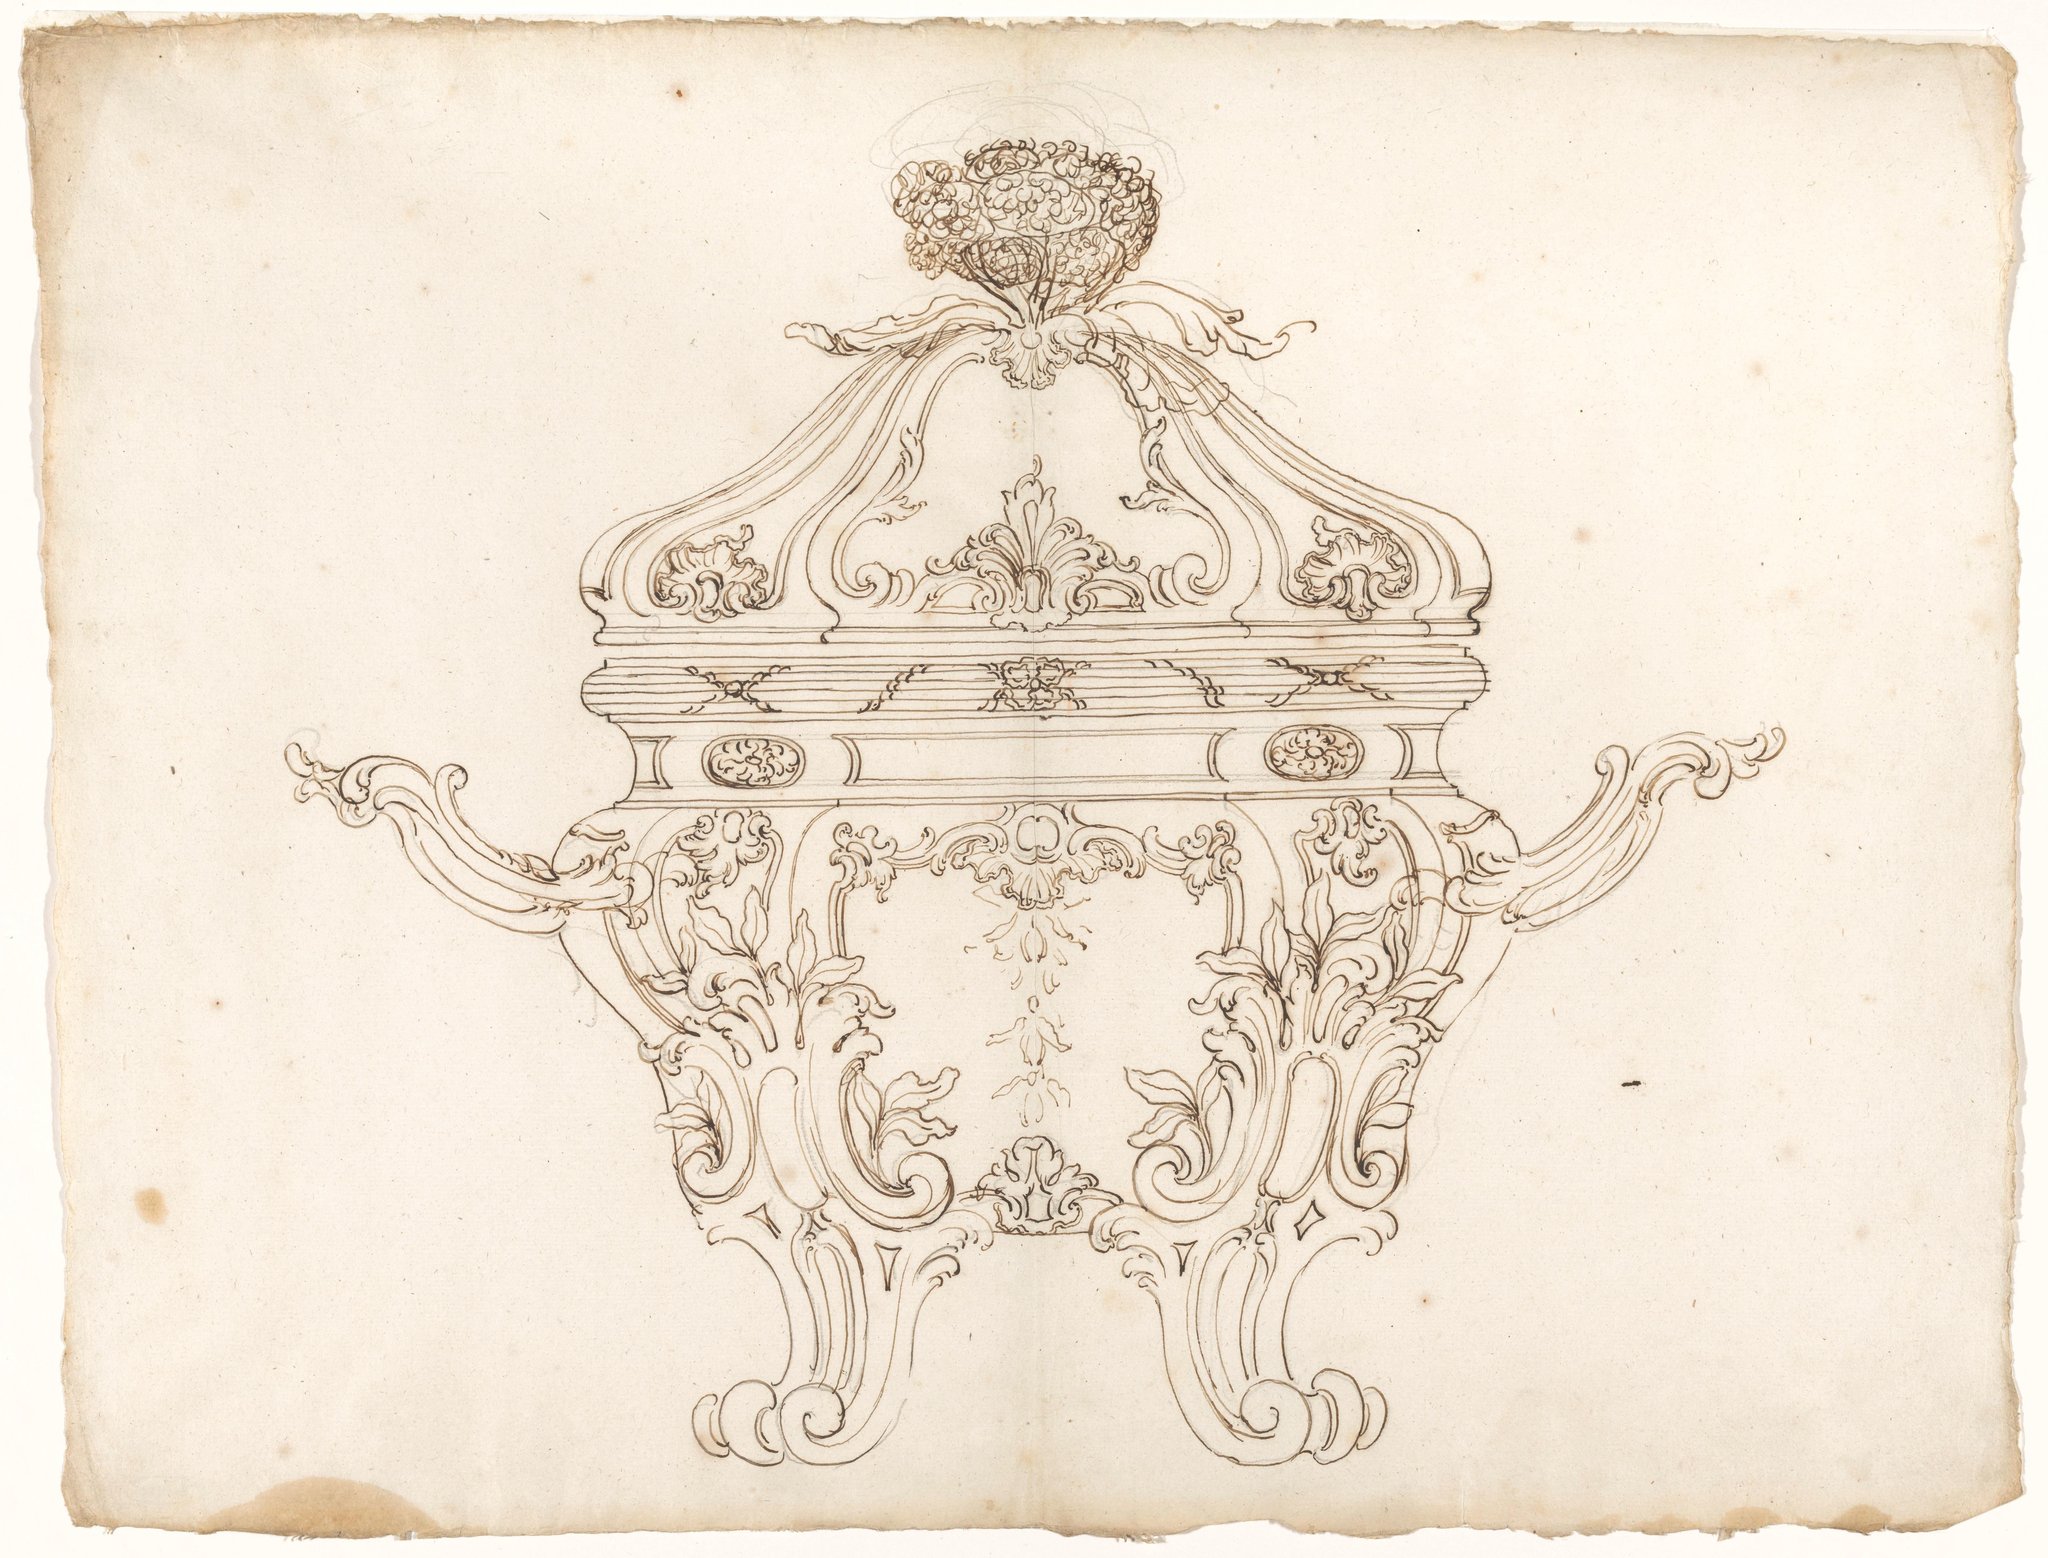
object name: drawing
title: Ronde terrine (pot à oille) met deksel dat door een kool wordt bekroond.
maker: Anonymous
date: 1750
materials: graphite, ink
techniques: drawing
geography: france